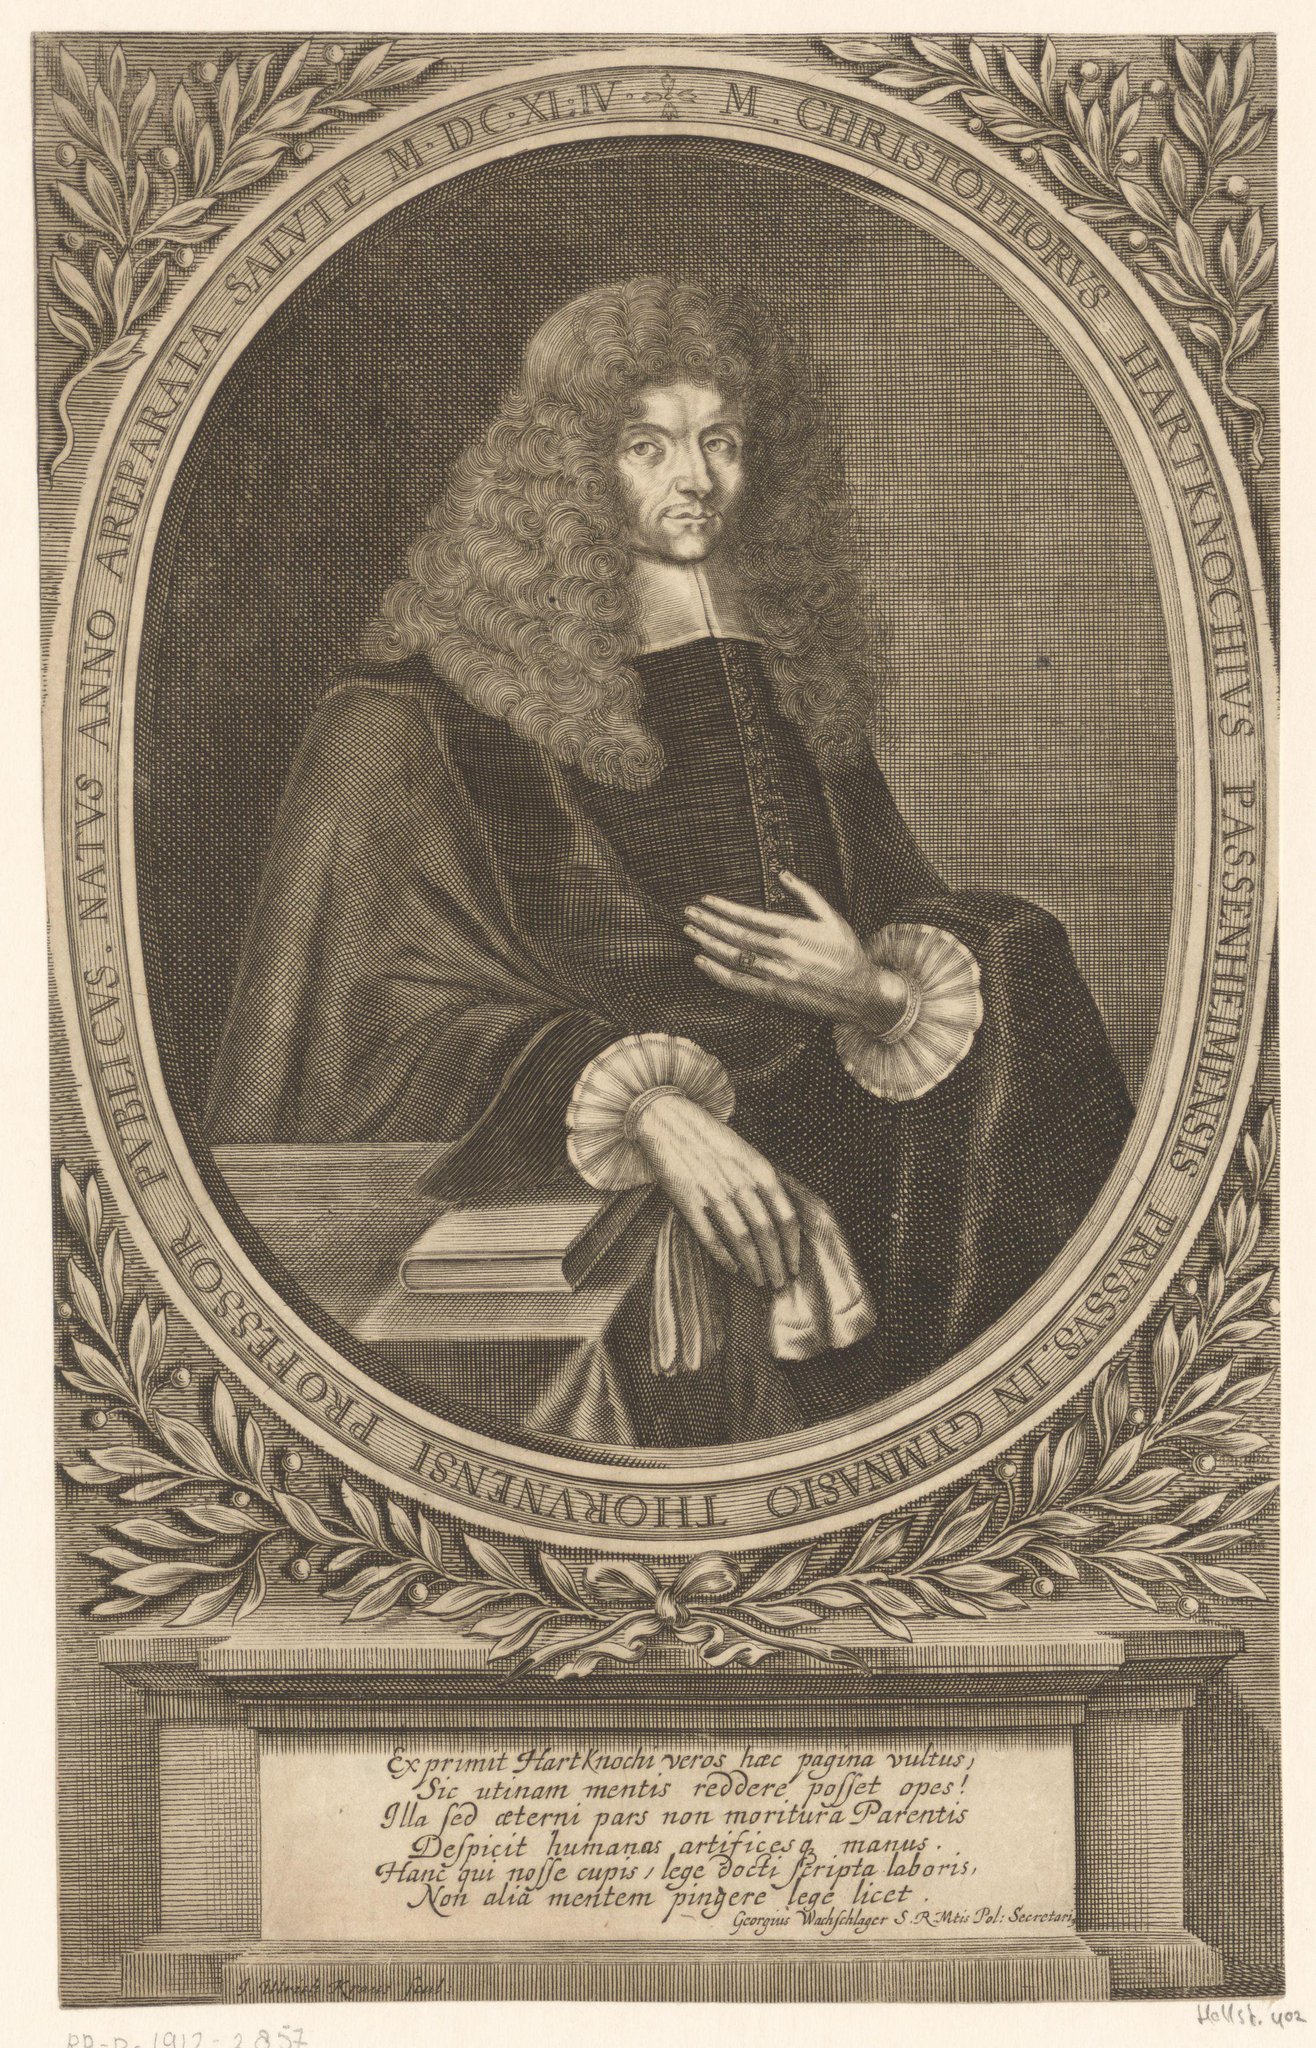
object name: print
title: Portret van Christoph Hartknoch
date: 1684-1714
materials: paper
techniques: engraving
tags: history and archaeology (+ portrait of scholar, scientist), gloves, mittens, etc., ethnology, cultural anthropology (+ portrait of scholar, scientist), historical persons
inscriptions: collector's mark: Lugt 2228